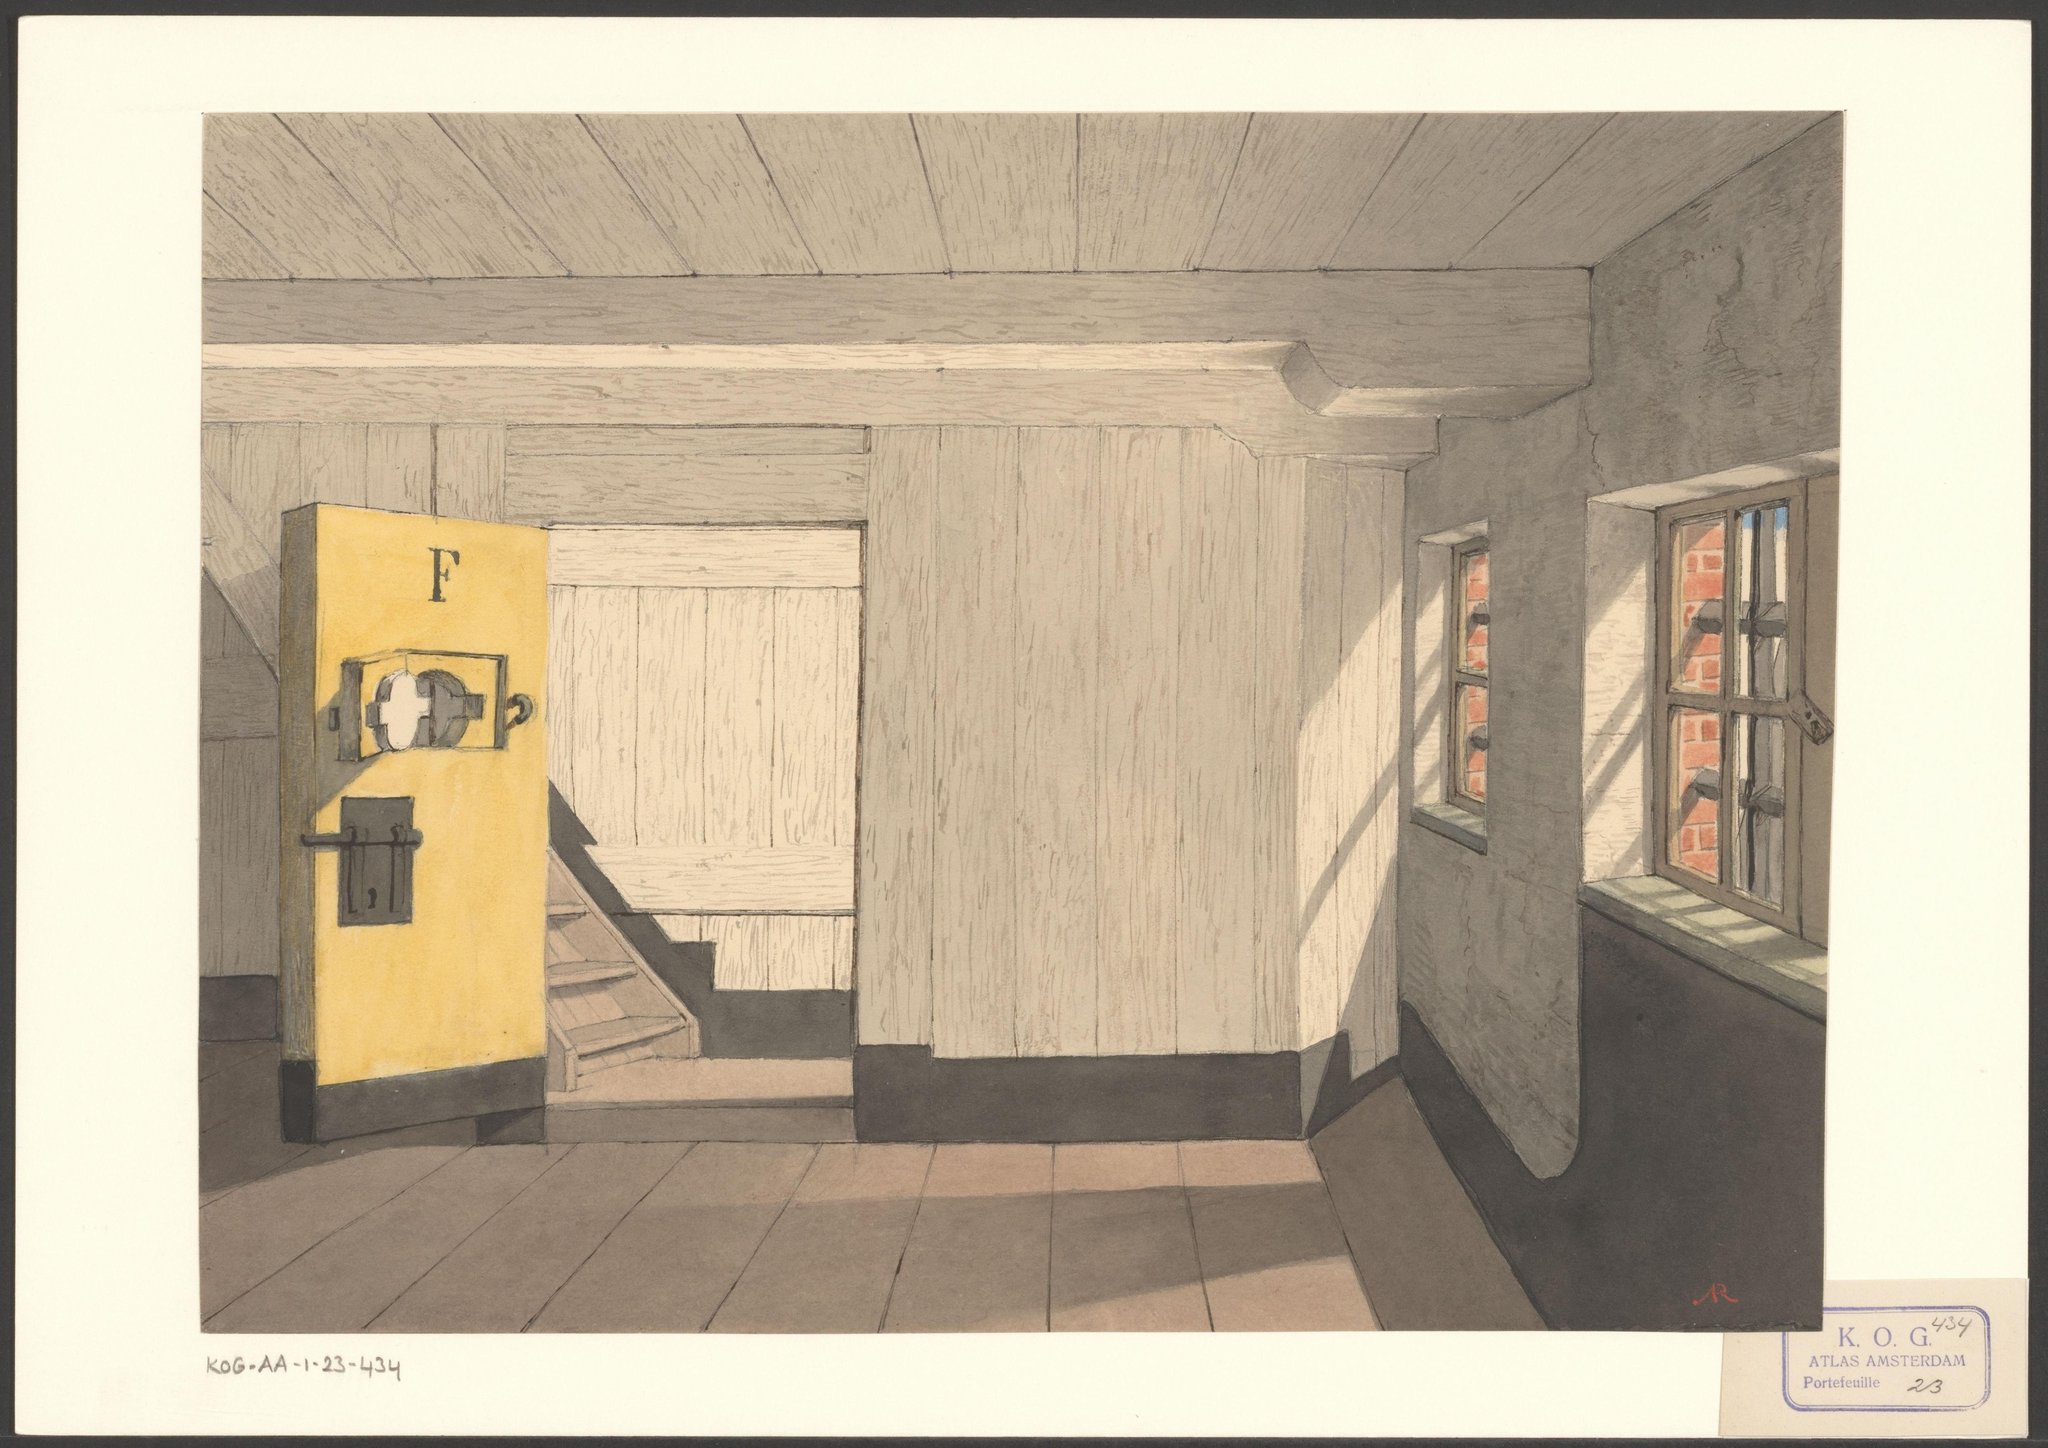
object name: drawing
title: Interieur van cel F in het Tucht- of Rasphuis aan de Heiligeweg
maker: johan martinus anthon rieke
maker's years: 1851-1899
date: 1895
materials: gouache, ink, paper, pencil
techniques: brush, pen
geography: amsterdam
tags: prison, jail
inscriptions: collector's mark: ‘23’ Lugt 1641b, signature, date and inscription: ‘Cel in het (...) fec 1895 Amsterdam.’, signature: ‘JMAR’, inscription: ‘Port. 23-434’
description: Onderwerpsrubriek binnen de Atlas Amsterdam: Handvesten, Keuren, enz.; Rechtswezen (incl. gevangenissen, enz.).